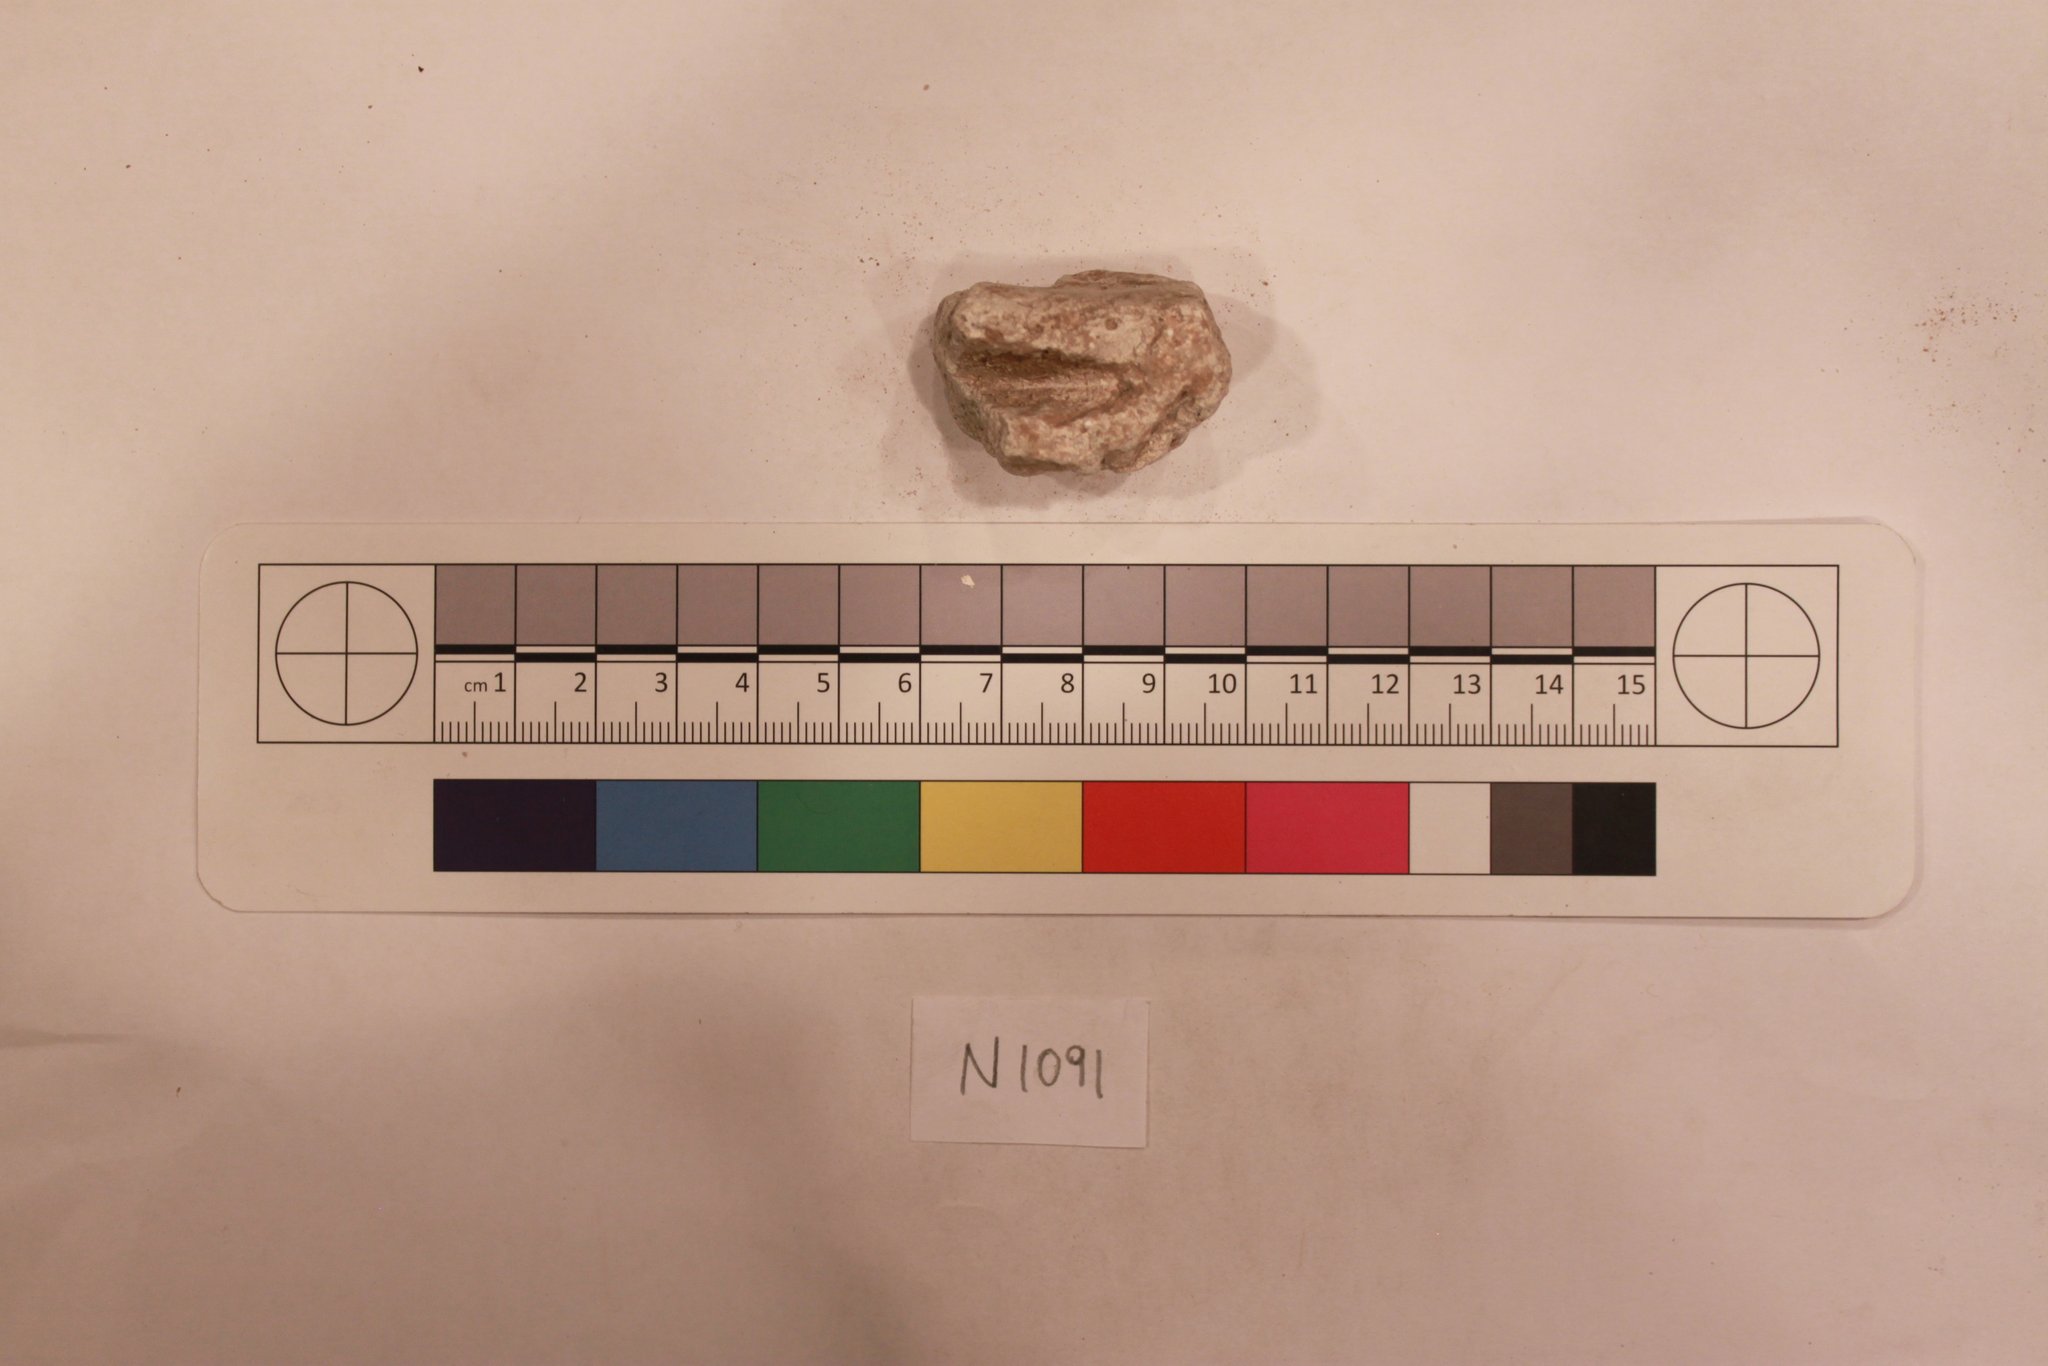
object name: fragment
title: Stucco Fragment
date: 701-1200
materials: plaster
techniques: carving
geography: iran